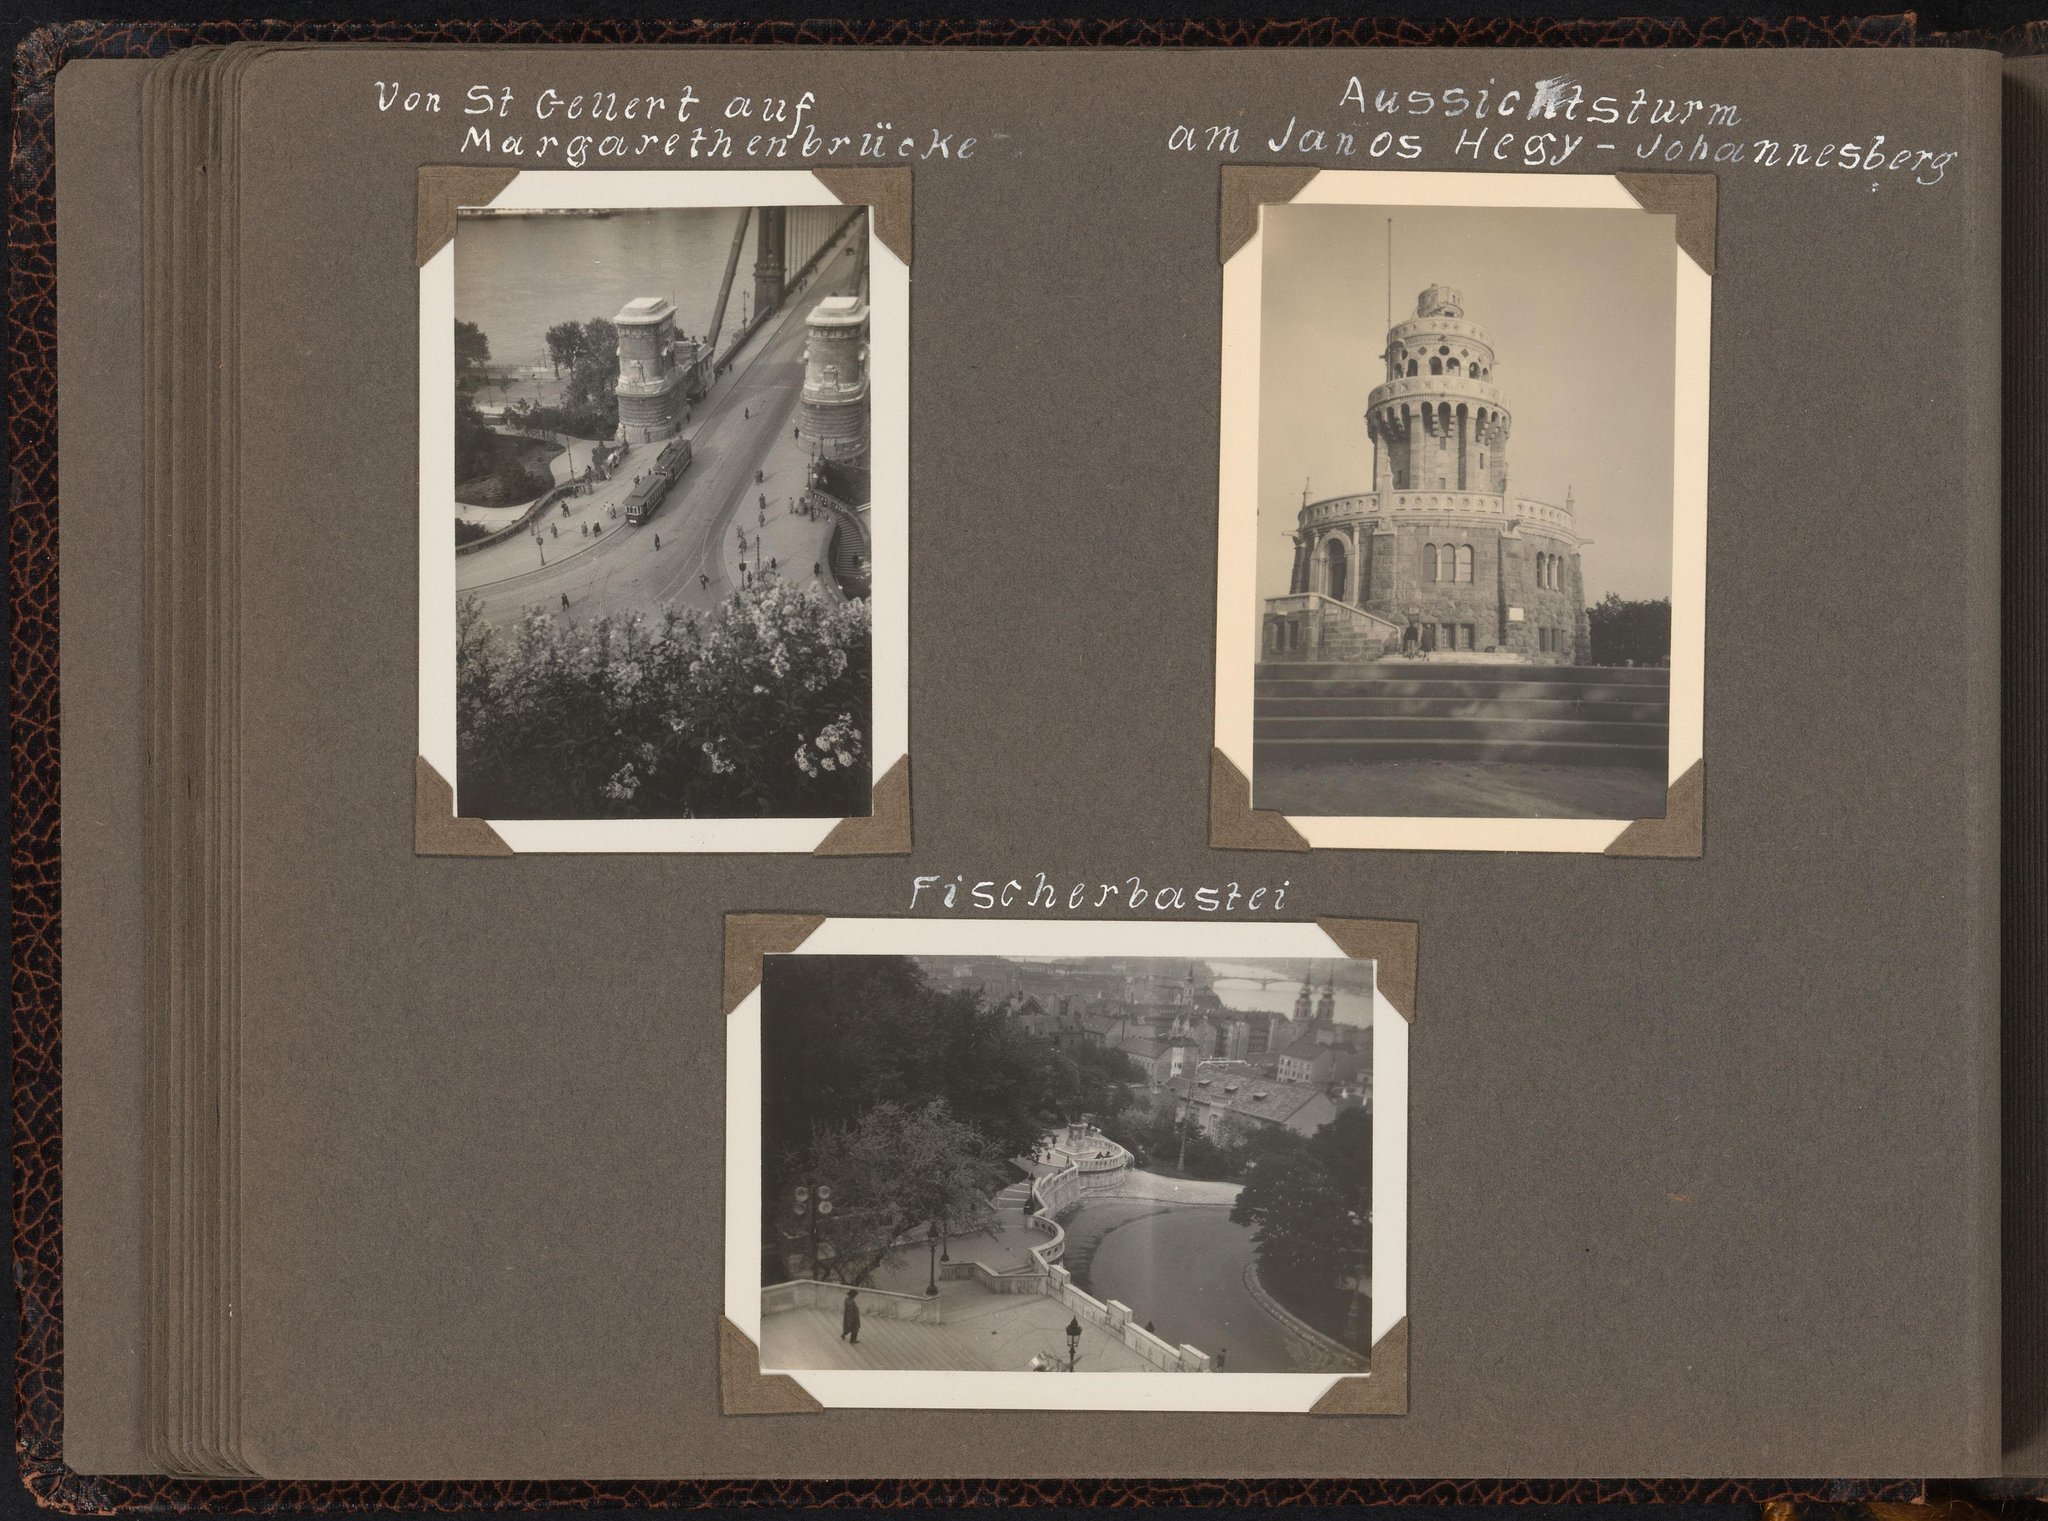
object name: album leaf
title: Verblijf in Budapest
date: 1930-1931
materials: cardboard, paper, photographic support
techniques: gelatin silver print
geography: budapest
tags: tower, clock tower ~ monumental adornment, city-view in general; 'veduta'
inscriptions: annotation: ‘Von st. Gellert auf Margarethenbrücke/ Aussichtsturm am Janos Hegy - Johannesberg/ Fischerbastei’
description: Drie foto's van bezienswaardigheden te Budapest. In de bijschriften worden de Gellértberg, de uitkijktoren op de Jánoshegy en het Vissersbastion vermeld. Deze pagina maakt deel uit van een album.